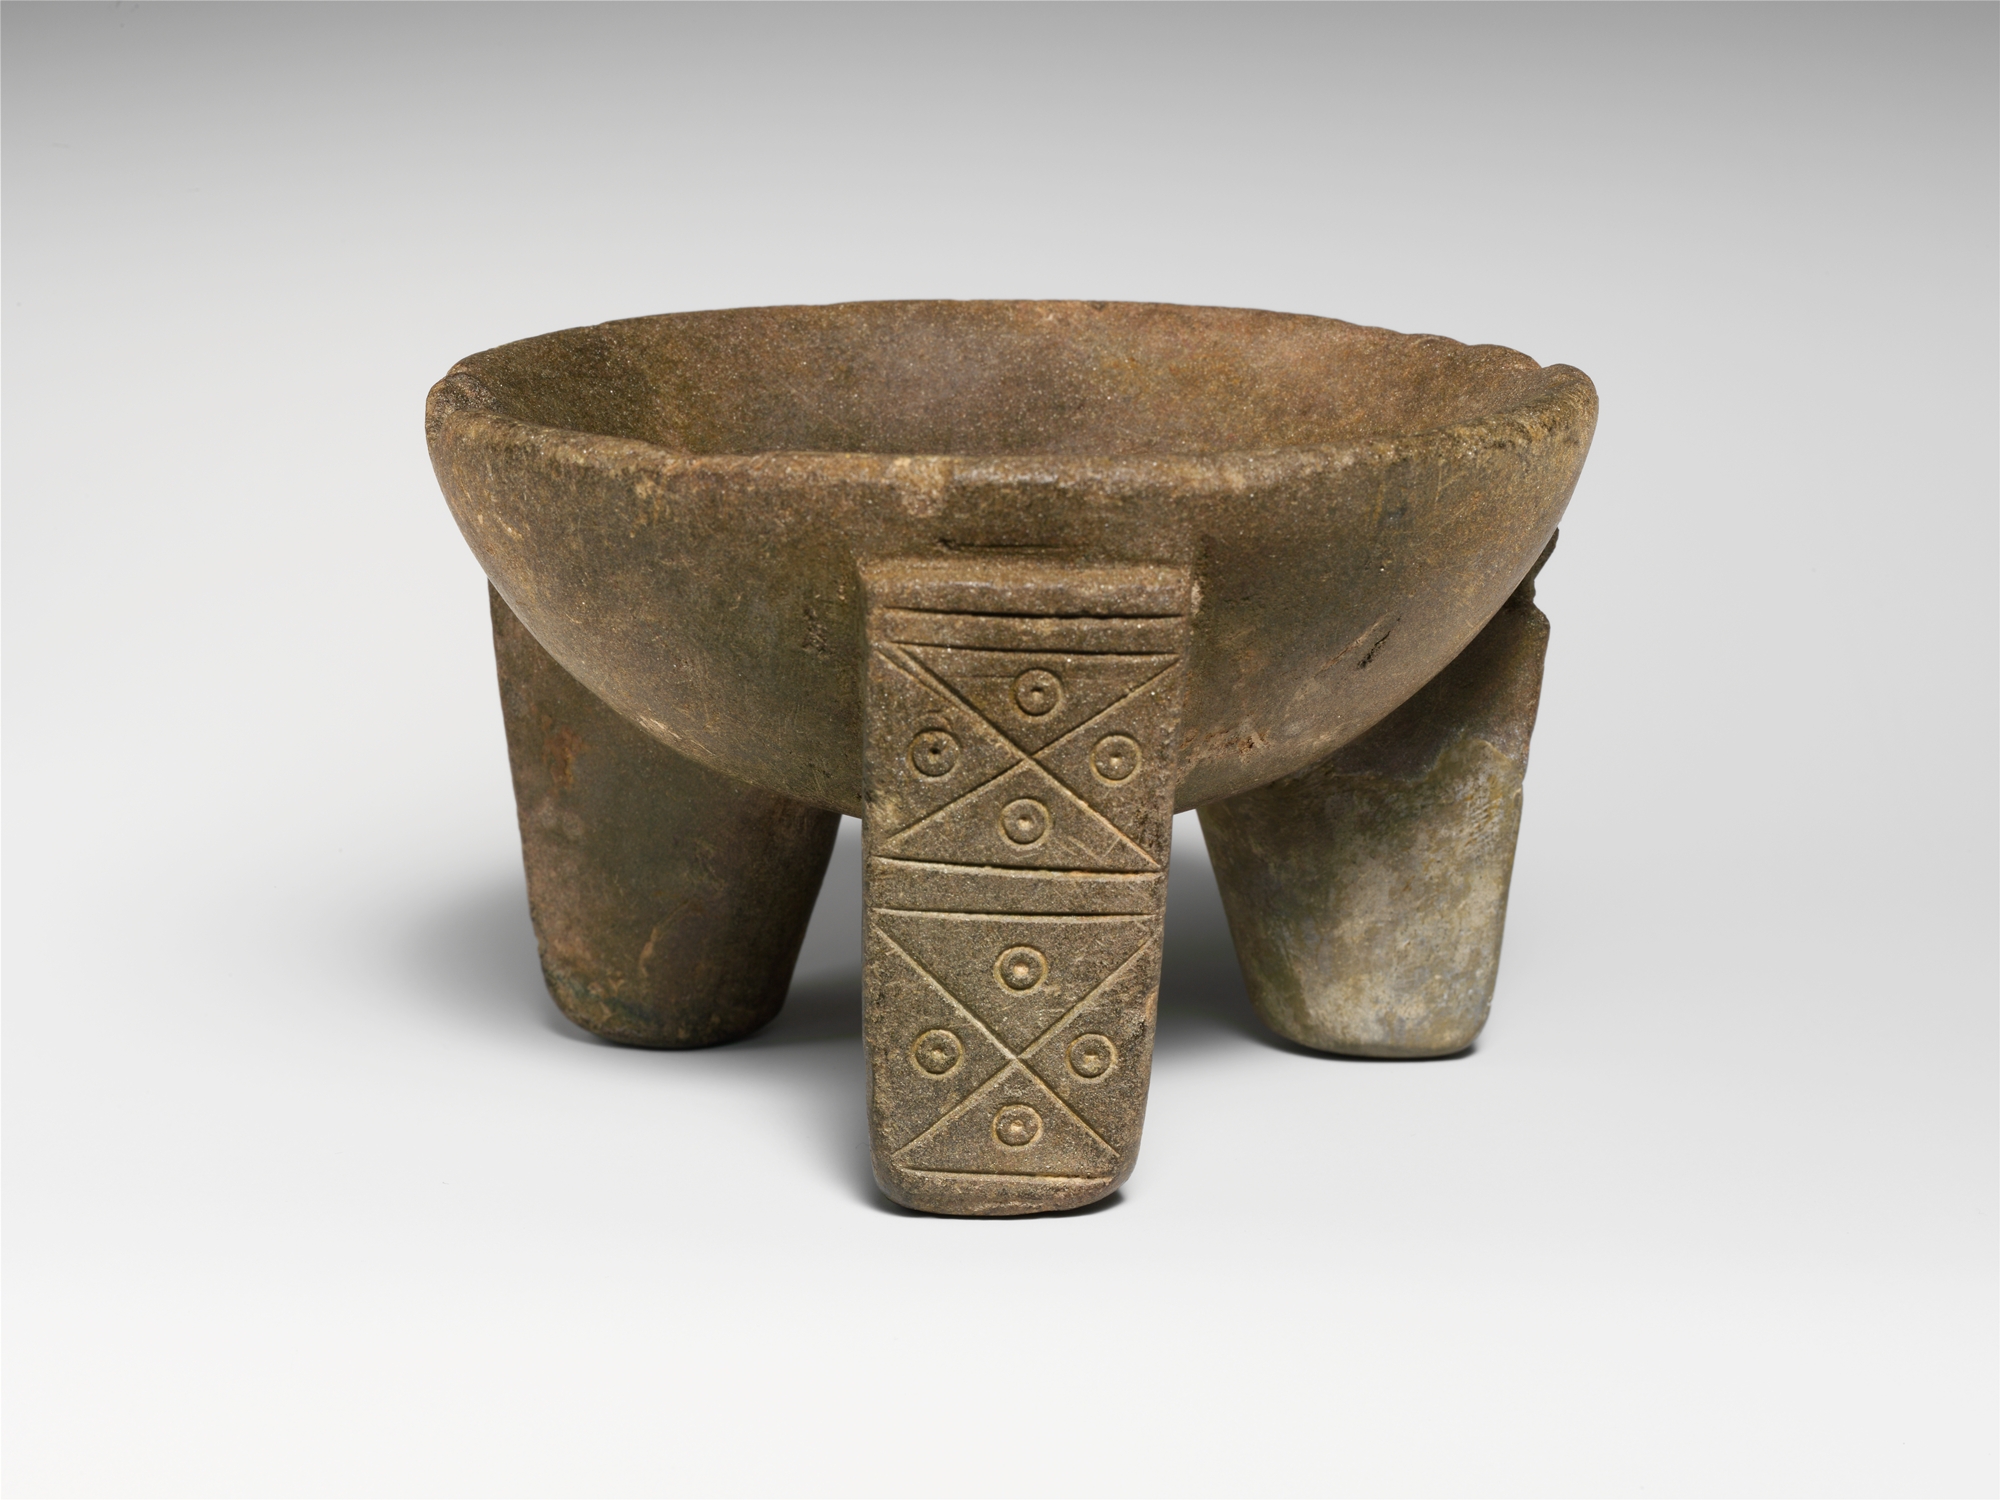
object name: tripod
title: Chlorite tripod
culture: cypriot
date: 1450-1050 BCE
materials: mineral